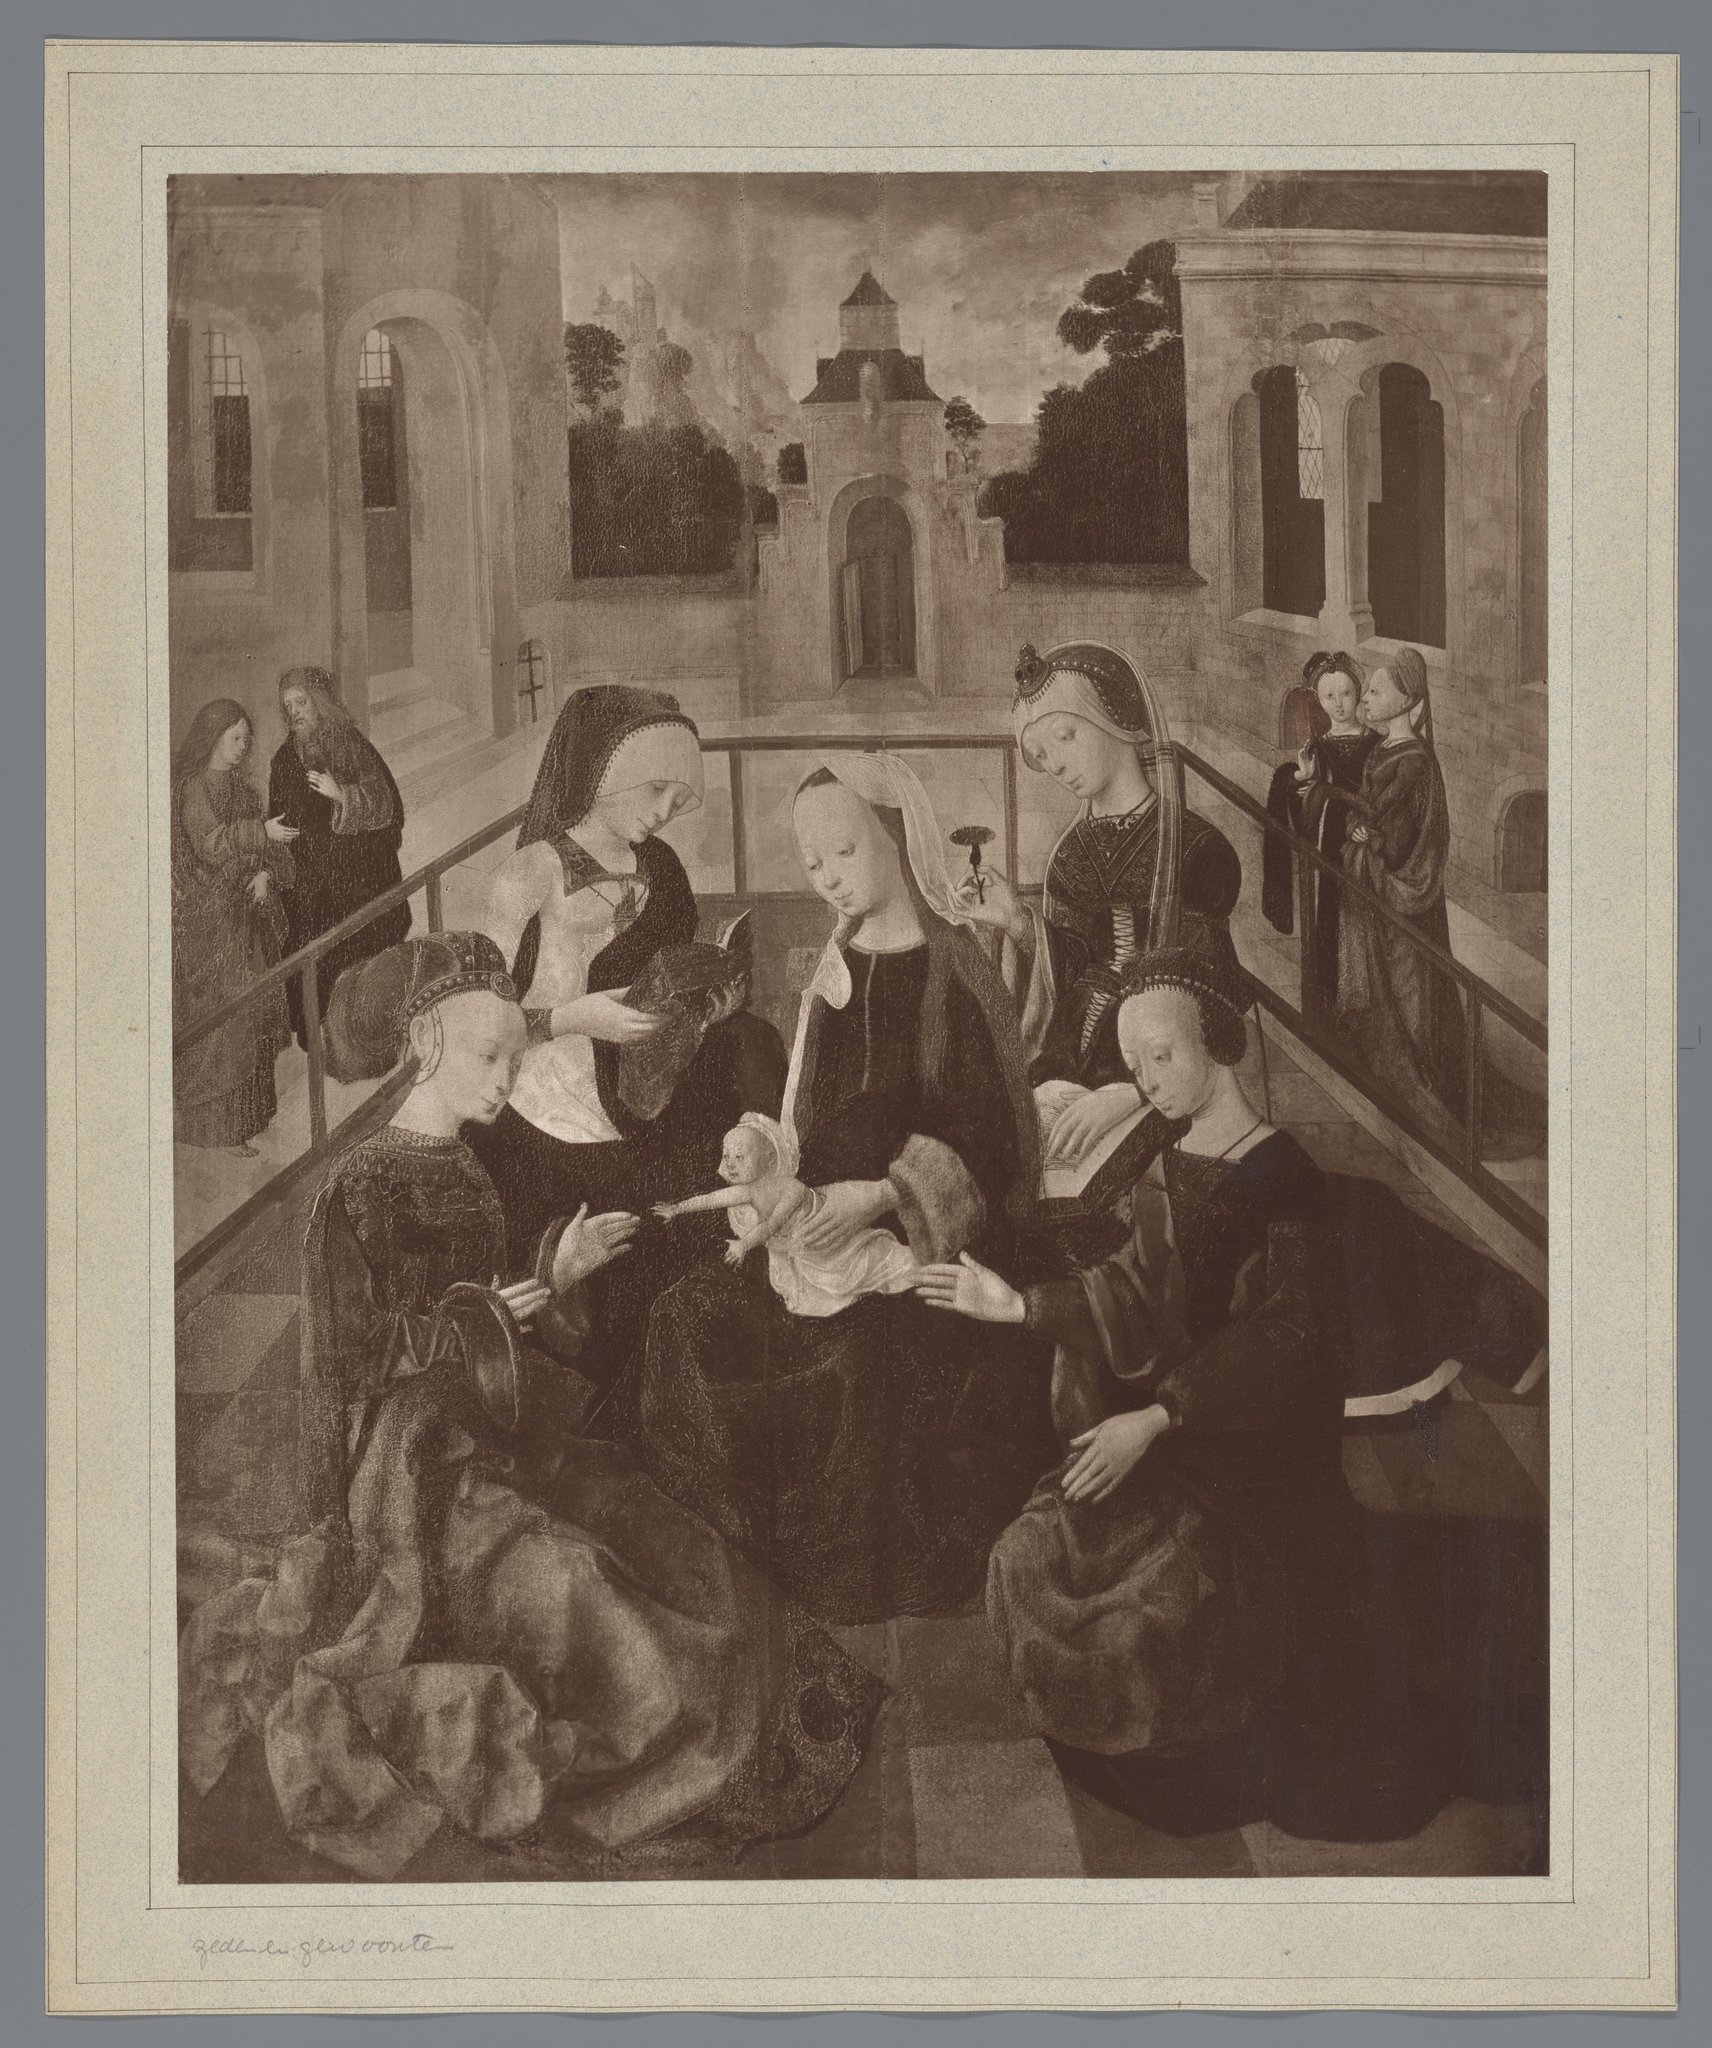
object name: photograph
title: Fotoreproductie van een schilderij van de Meester van de Virgo inter Virgines, 'Maria met kind en de heiligen Catharina, Cecilia, Barbara en Ursula' (coll. Rijksmuseum)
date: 1880-1900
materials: cardboard, paper, photographic support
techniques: carbon print